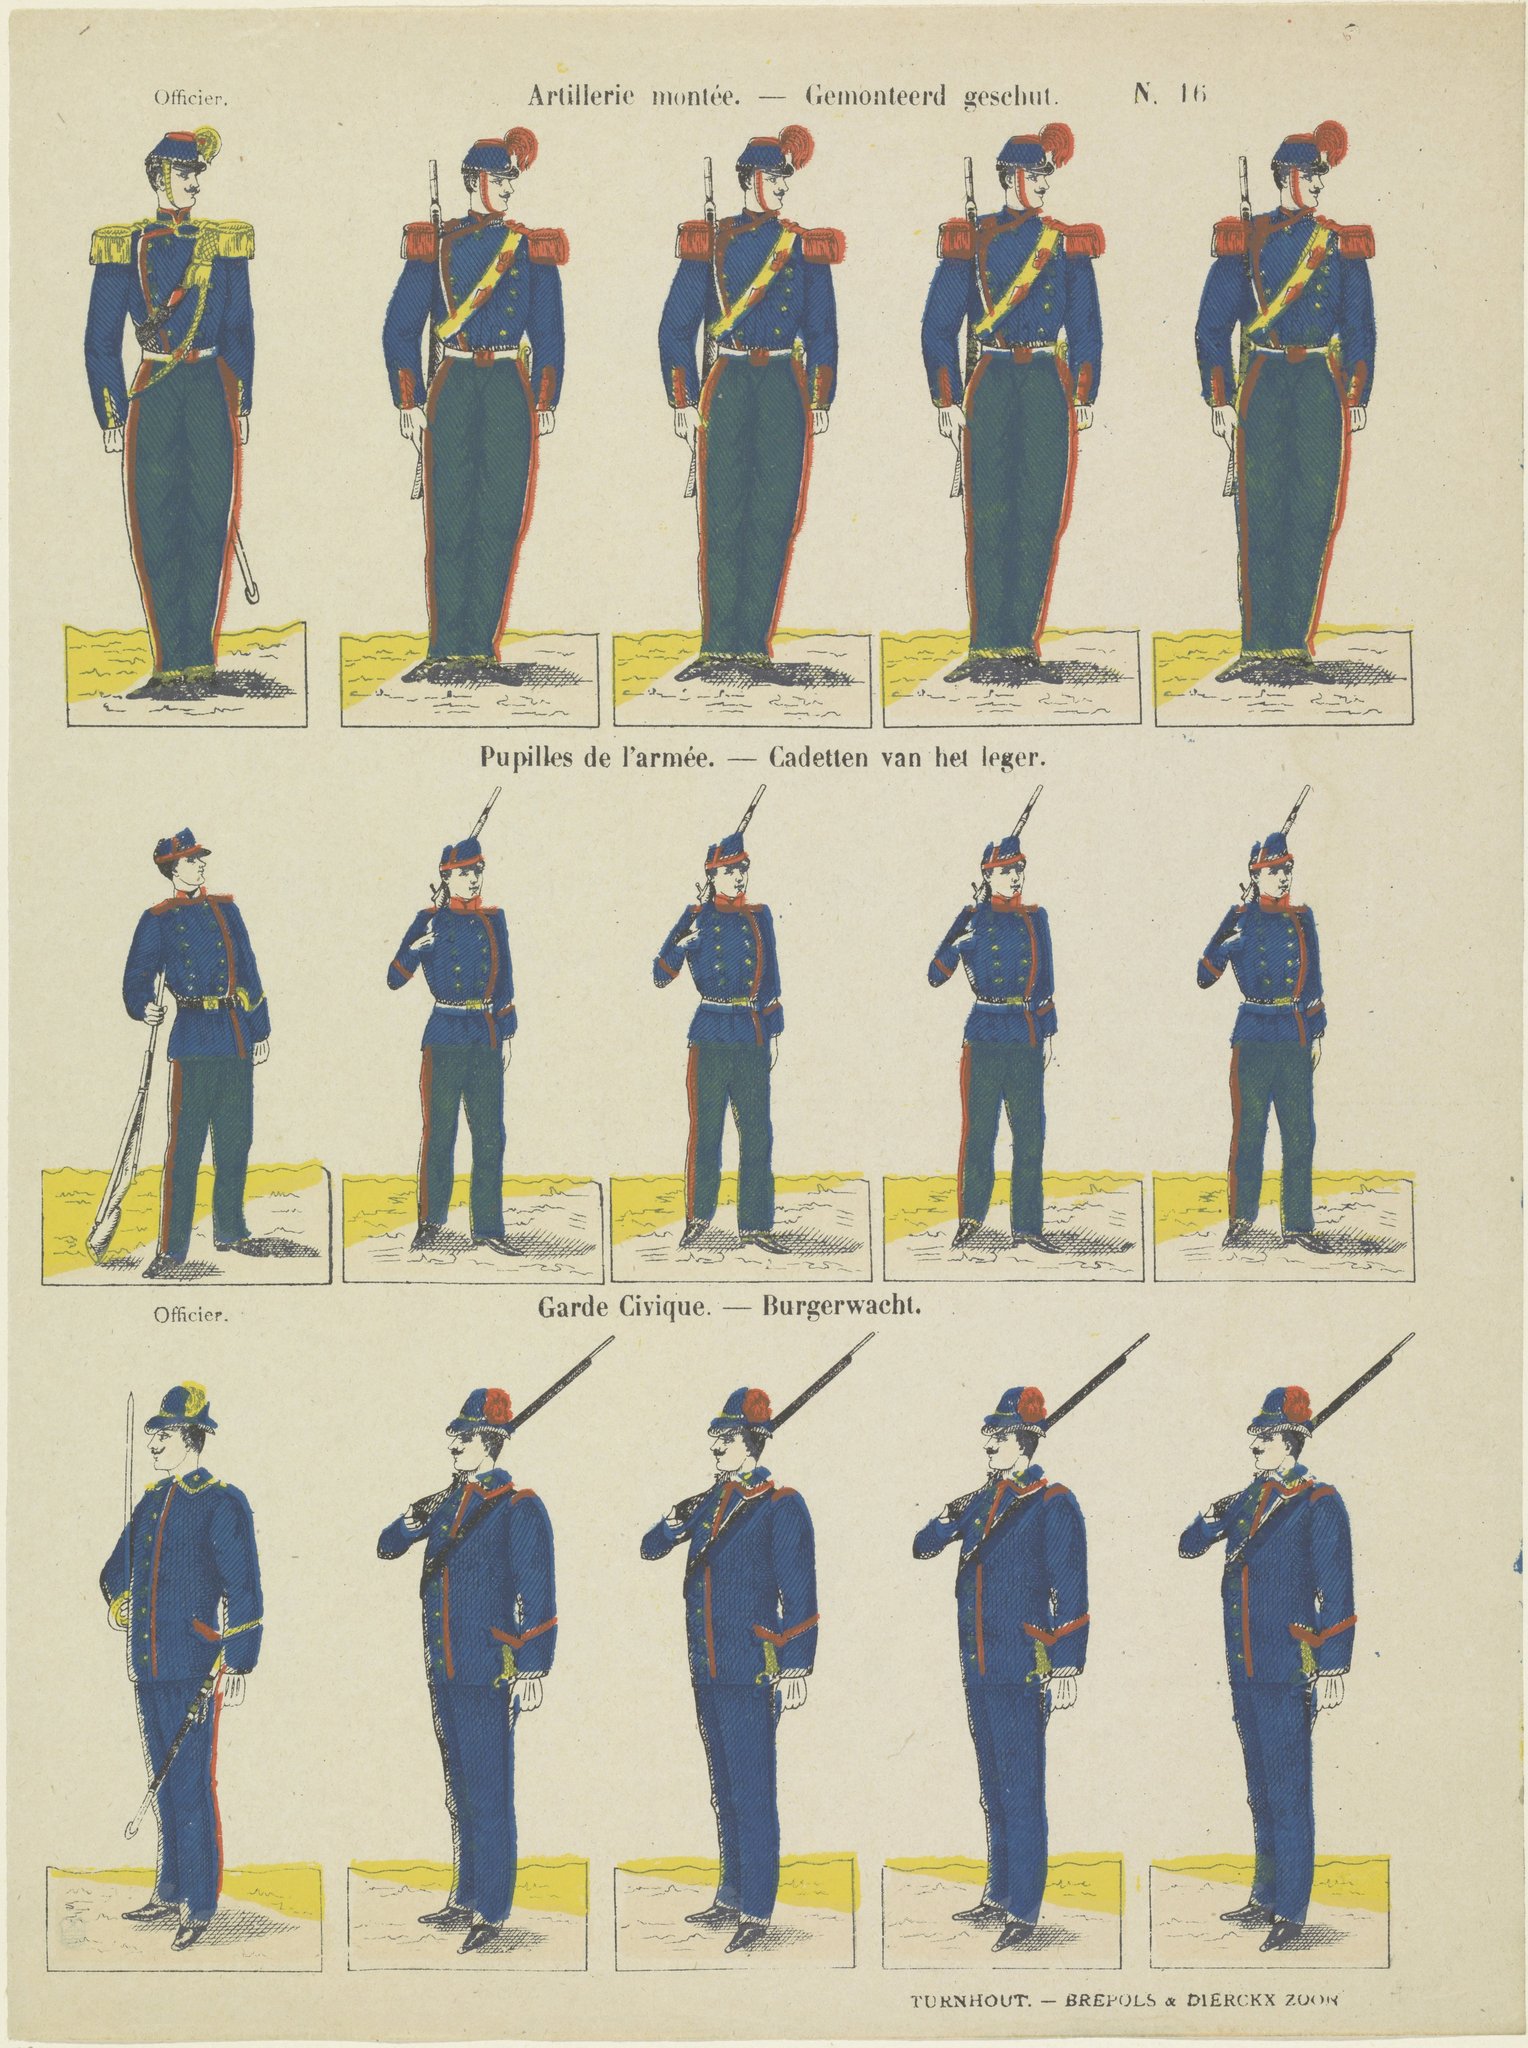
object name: print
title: Artillerie montée / Gemonteerd geschut / Pupilles de l'armée / Cadetten van het leger / Garde civique / Burgerwacht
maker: Anonymous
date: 1833-1911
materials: paper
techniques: lithograph, letterpress printing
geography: turnhout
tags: the soldier; the soldier's life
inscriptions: collector's mark: Lugt 2760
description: Blad met 3 horizontale rijen met in totaal 15 voorstellingen van officieren en militairen met geweren. Genummerd rechtsboven: N. 16.